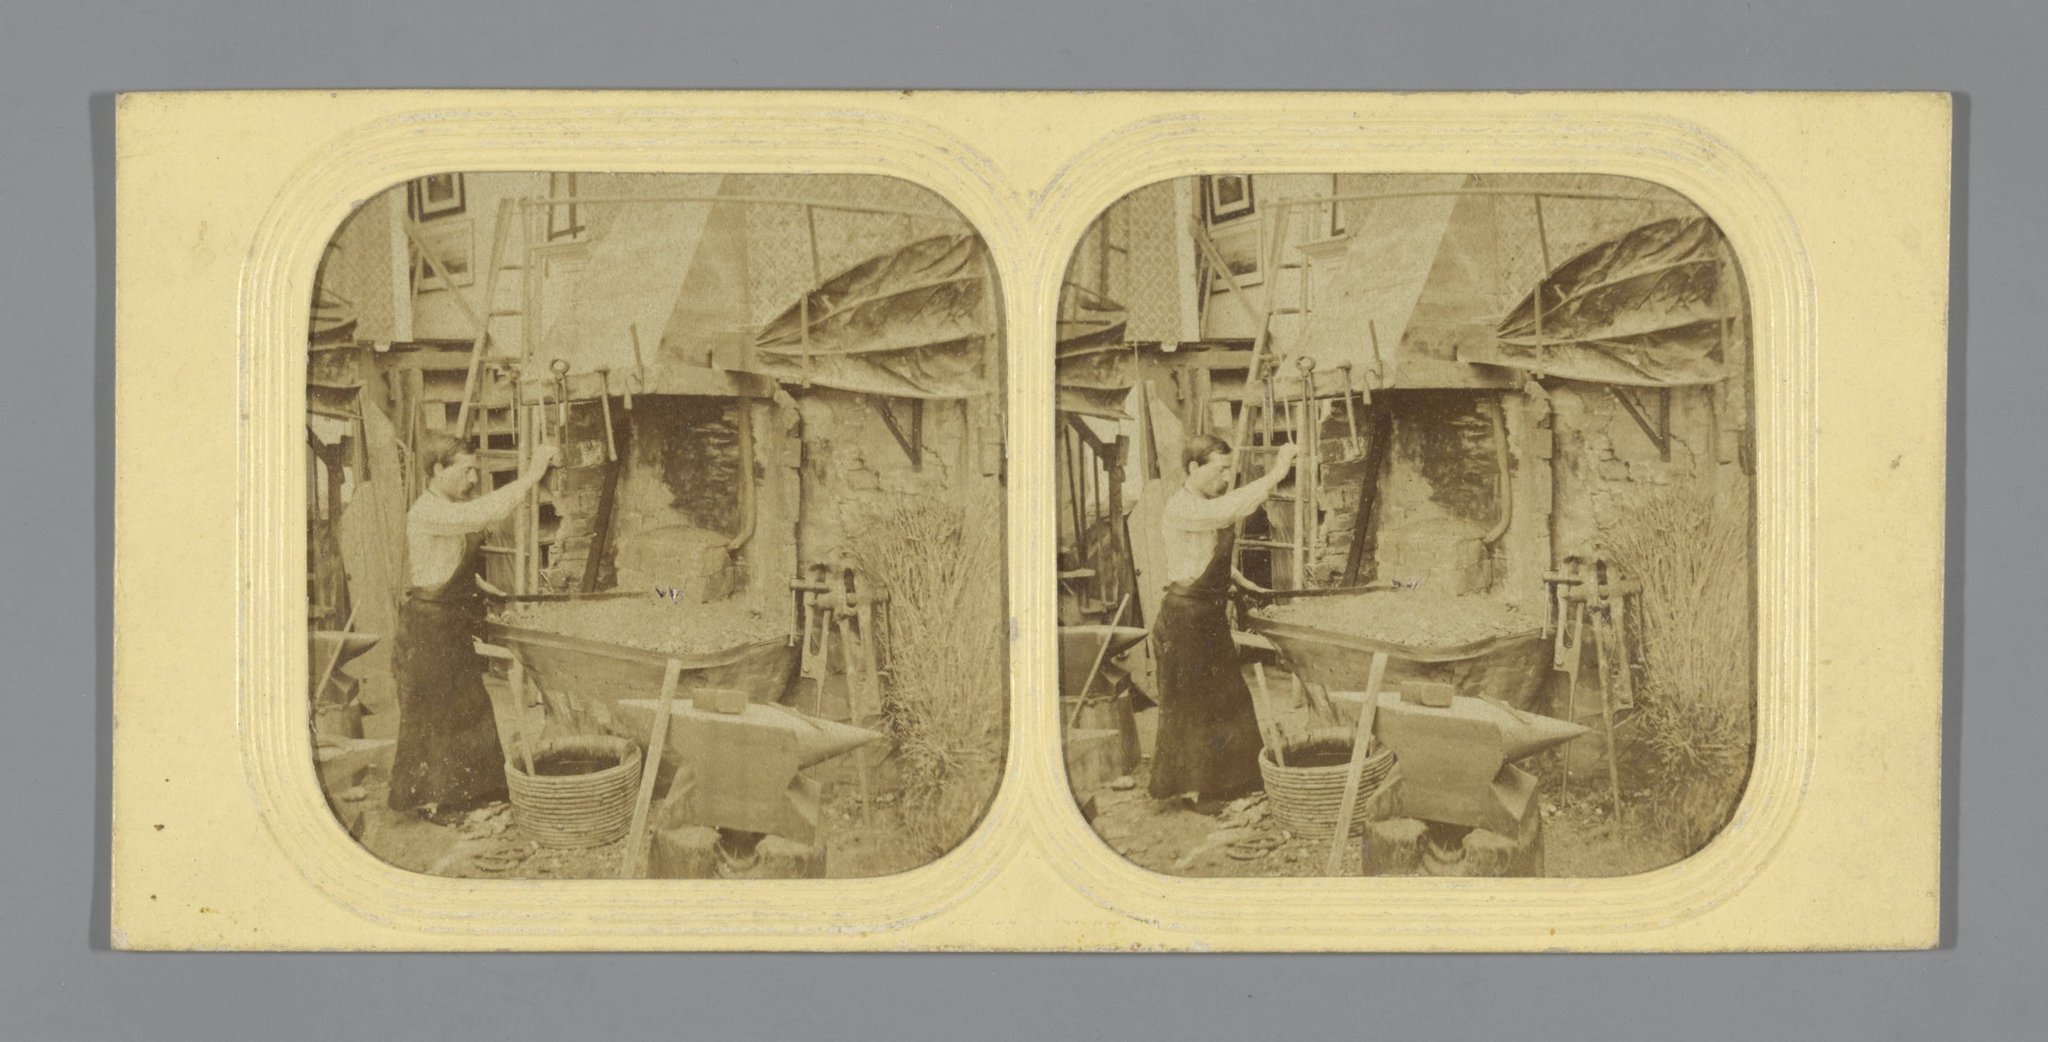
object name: tissue stereograph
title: Smid aan het werk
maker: Anonymous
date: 1855-1875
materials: cardboard, paper, photographic support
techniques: albumen print, cutting, hand coloring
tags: smith, blacksmith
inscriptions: inscription: ‘90 ct’, number: ‘42’